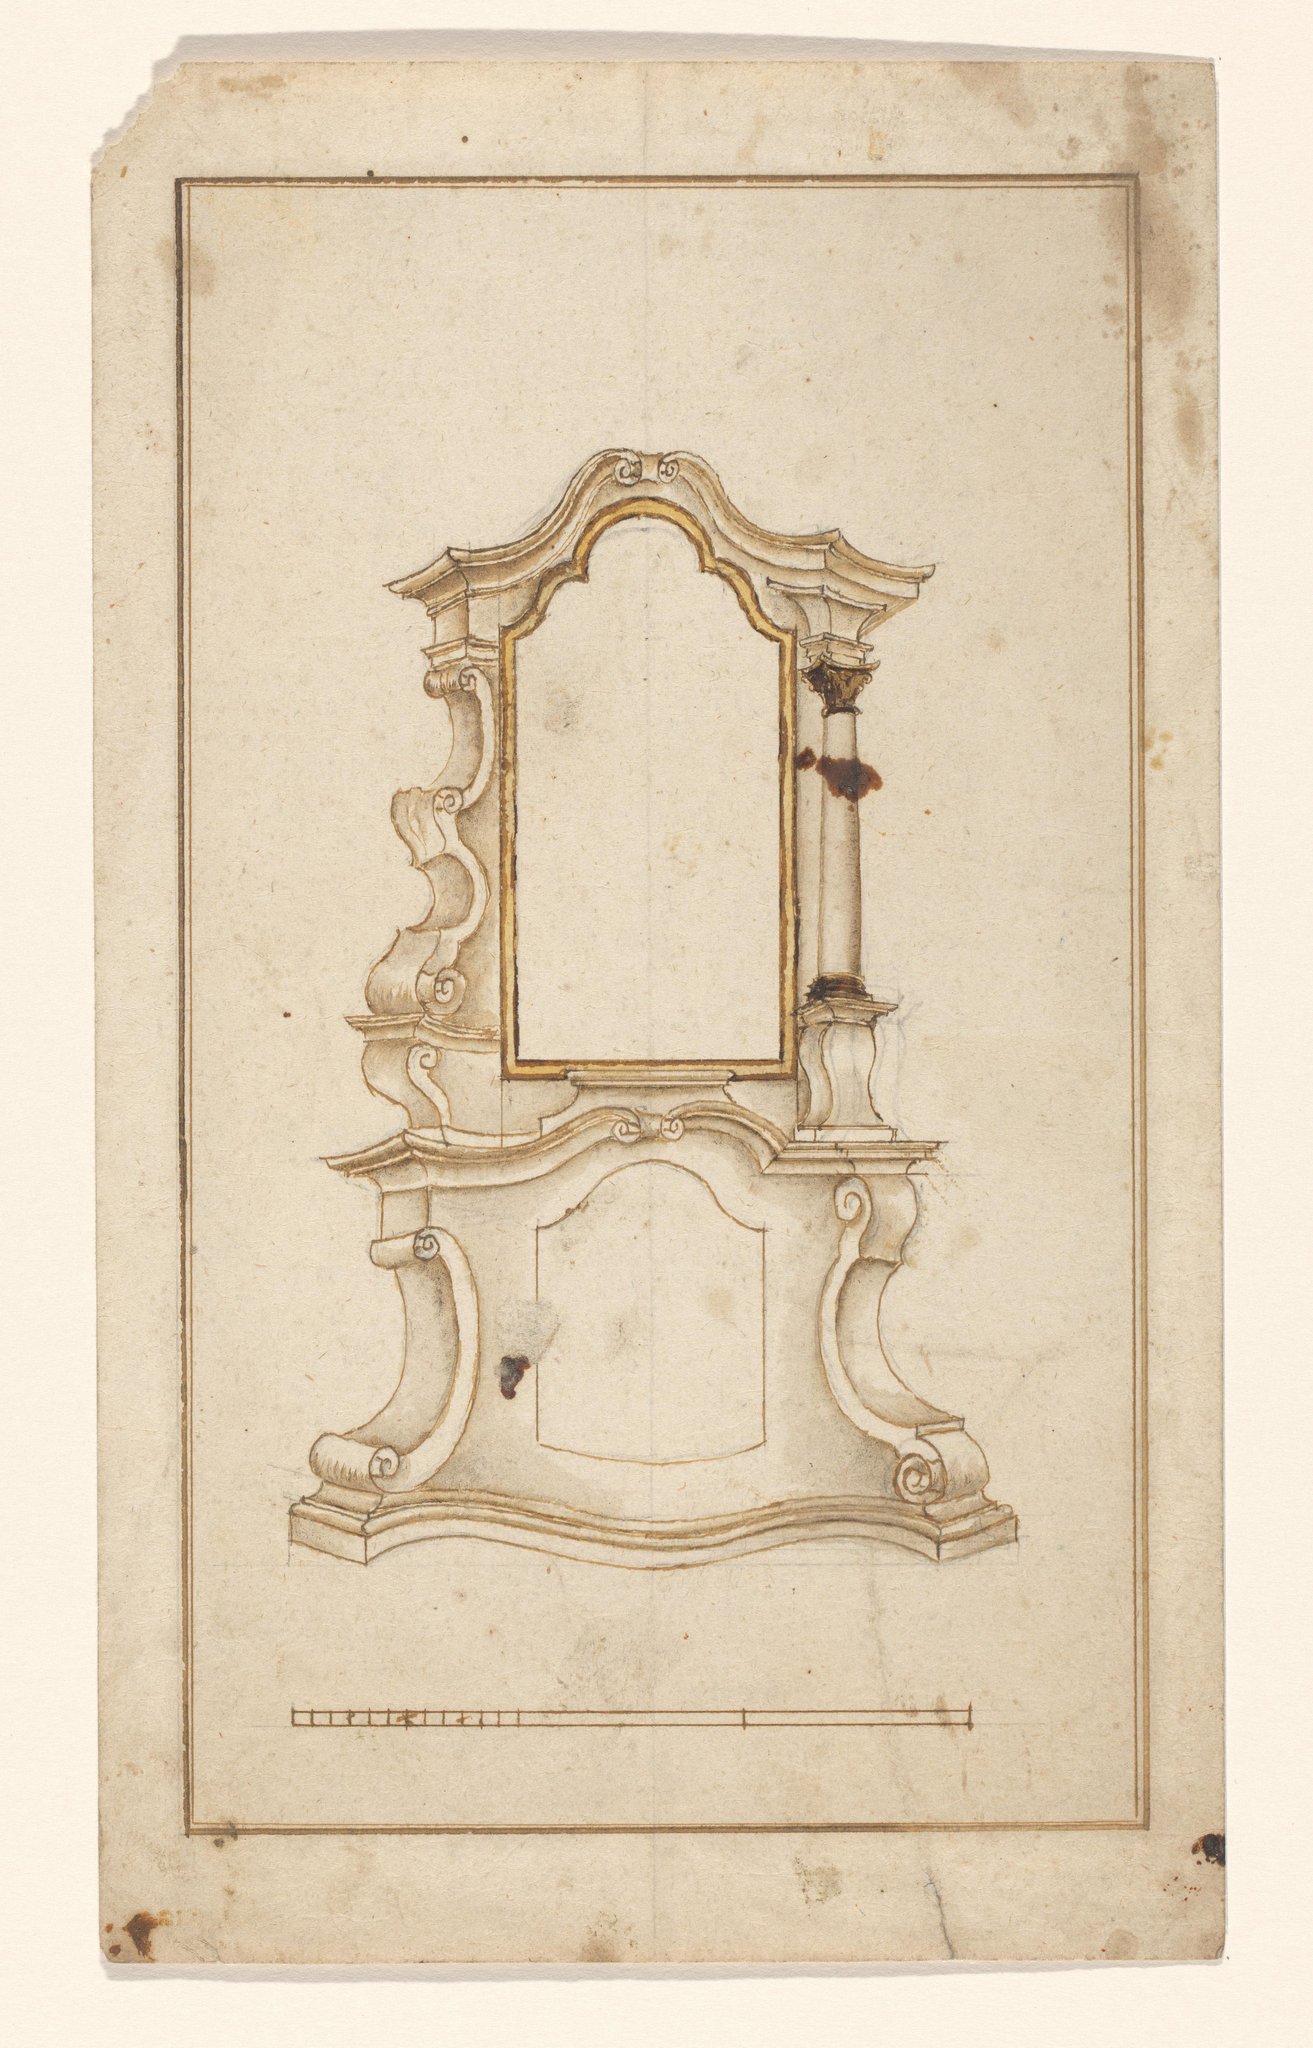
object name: design drawing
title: Ontwerp voor een altaar, met links en rechts alternatieve oplossingen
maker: Anonymous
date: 1745-1755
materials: graphite, ink, paper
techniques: brush, pen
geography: germany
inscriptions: inscription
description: Aan de onderzijde een maatstaf. Verso een schets in grafiet van een leuning (?).